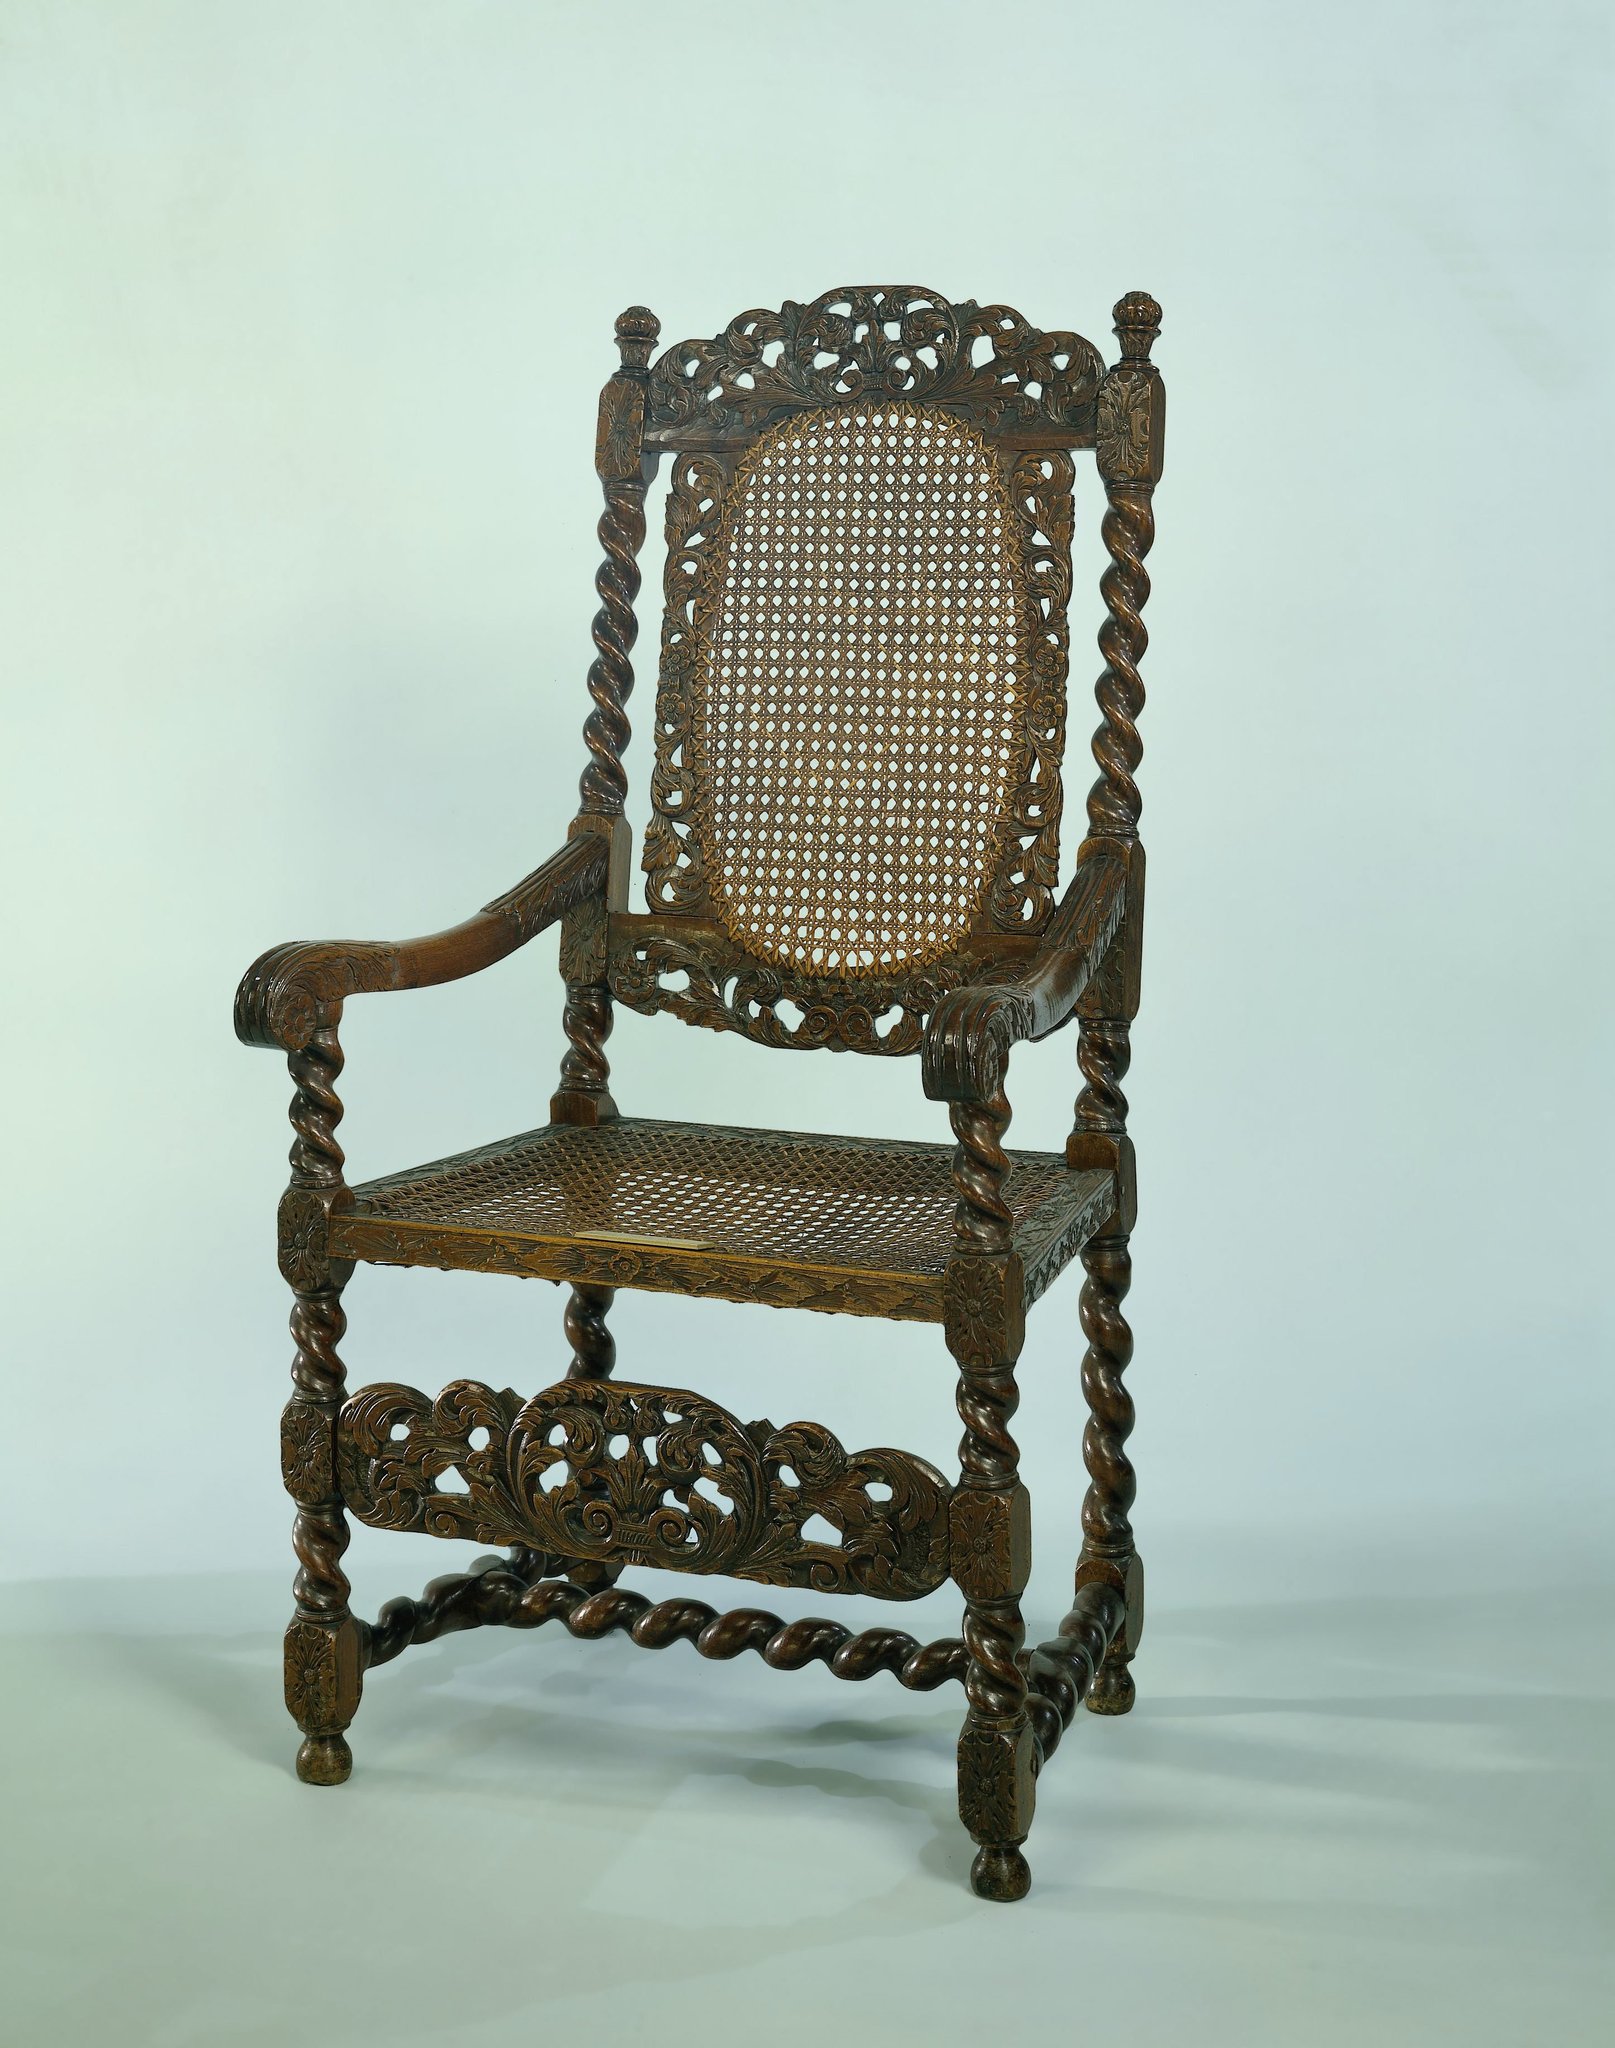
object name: armchair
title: Armstoel waarvan de geslingerde rugstijlen worden bekroond door gedraaide vazen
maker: Anonymous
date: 1650-1700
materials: wood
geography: northern netherlands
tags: acanthus ~ ornament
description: Armchair. Walnut and cane. Northern Netherlands, 2nd half 17th century.